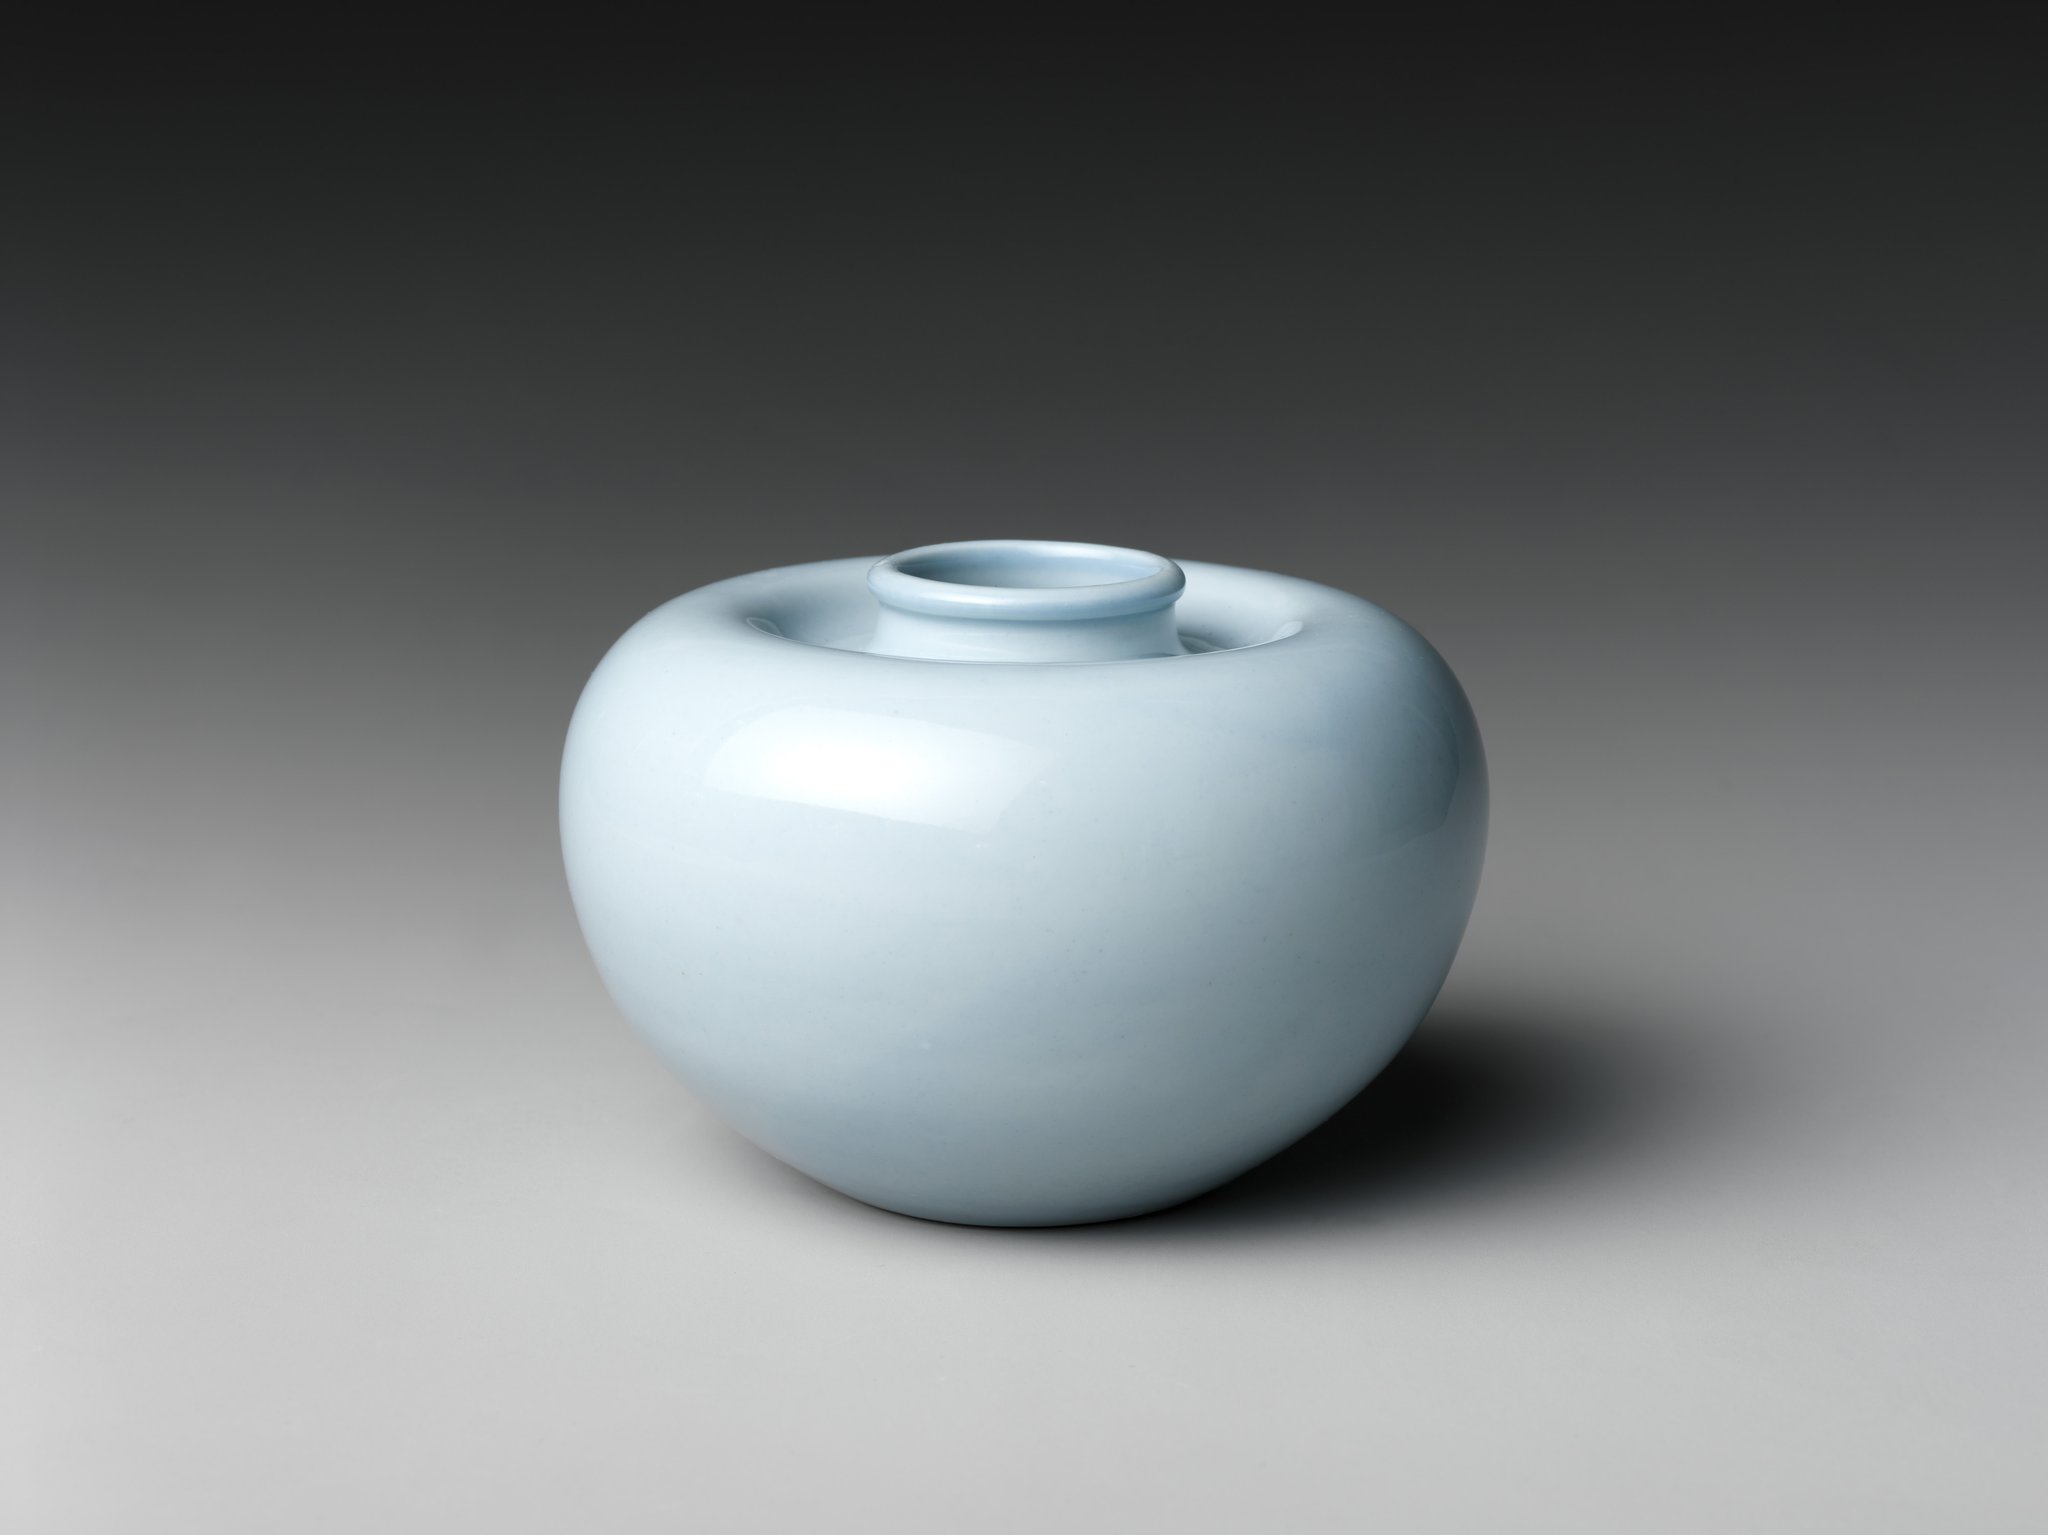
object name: jar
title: Water Jar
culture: chinese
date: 1689-1712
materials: glaze, porcelain